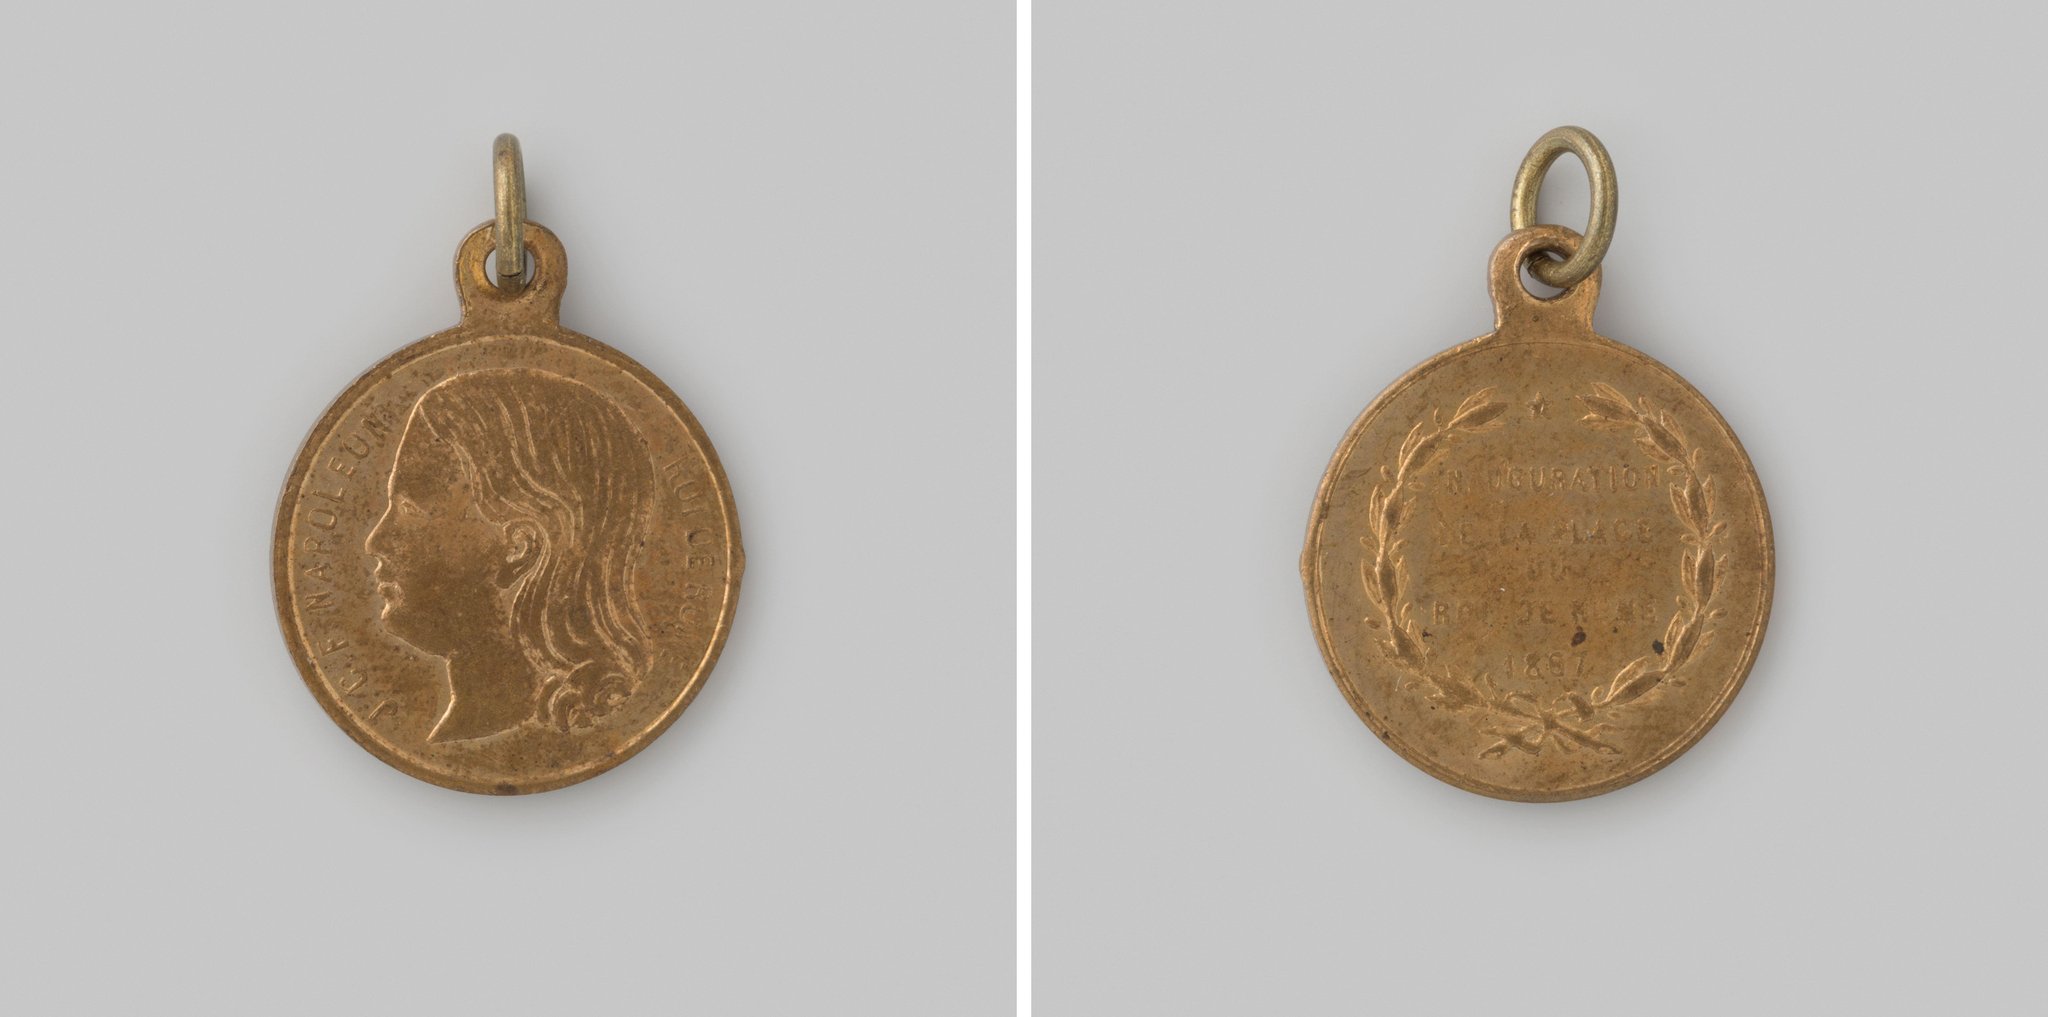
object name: history medal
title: Inwijding van de Place du Roi de Rome te Parijs 1867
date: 1867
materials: brass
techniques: striking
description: Verguld penninkje met oog en draagring, op de voorzijde het portret van J.C.F. Napoleon naar links met omschrift, op de keerzijde vijf regels tekst.